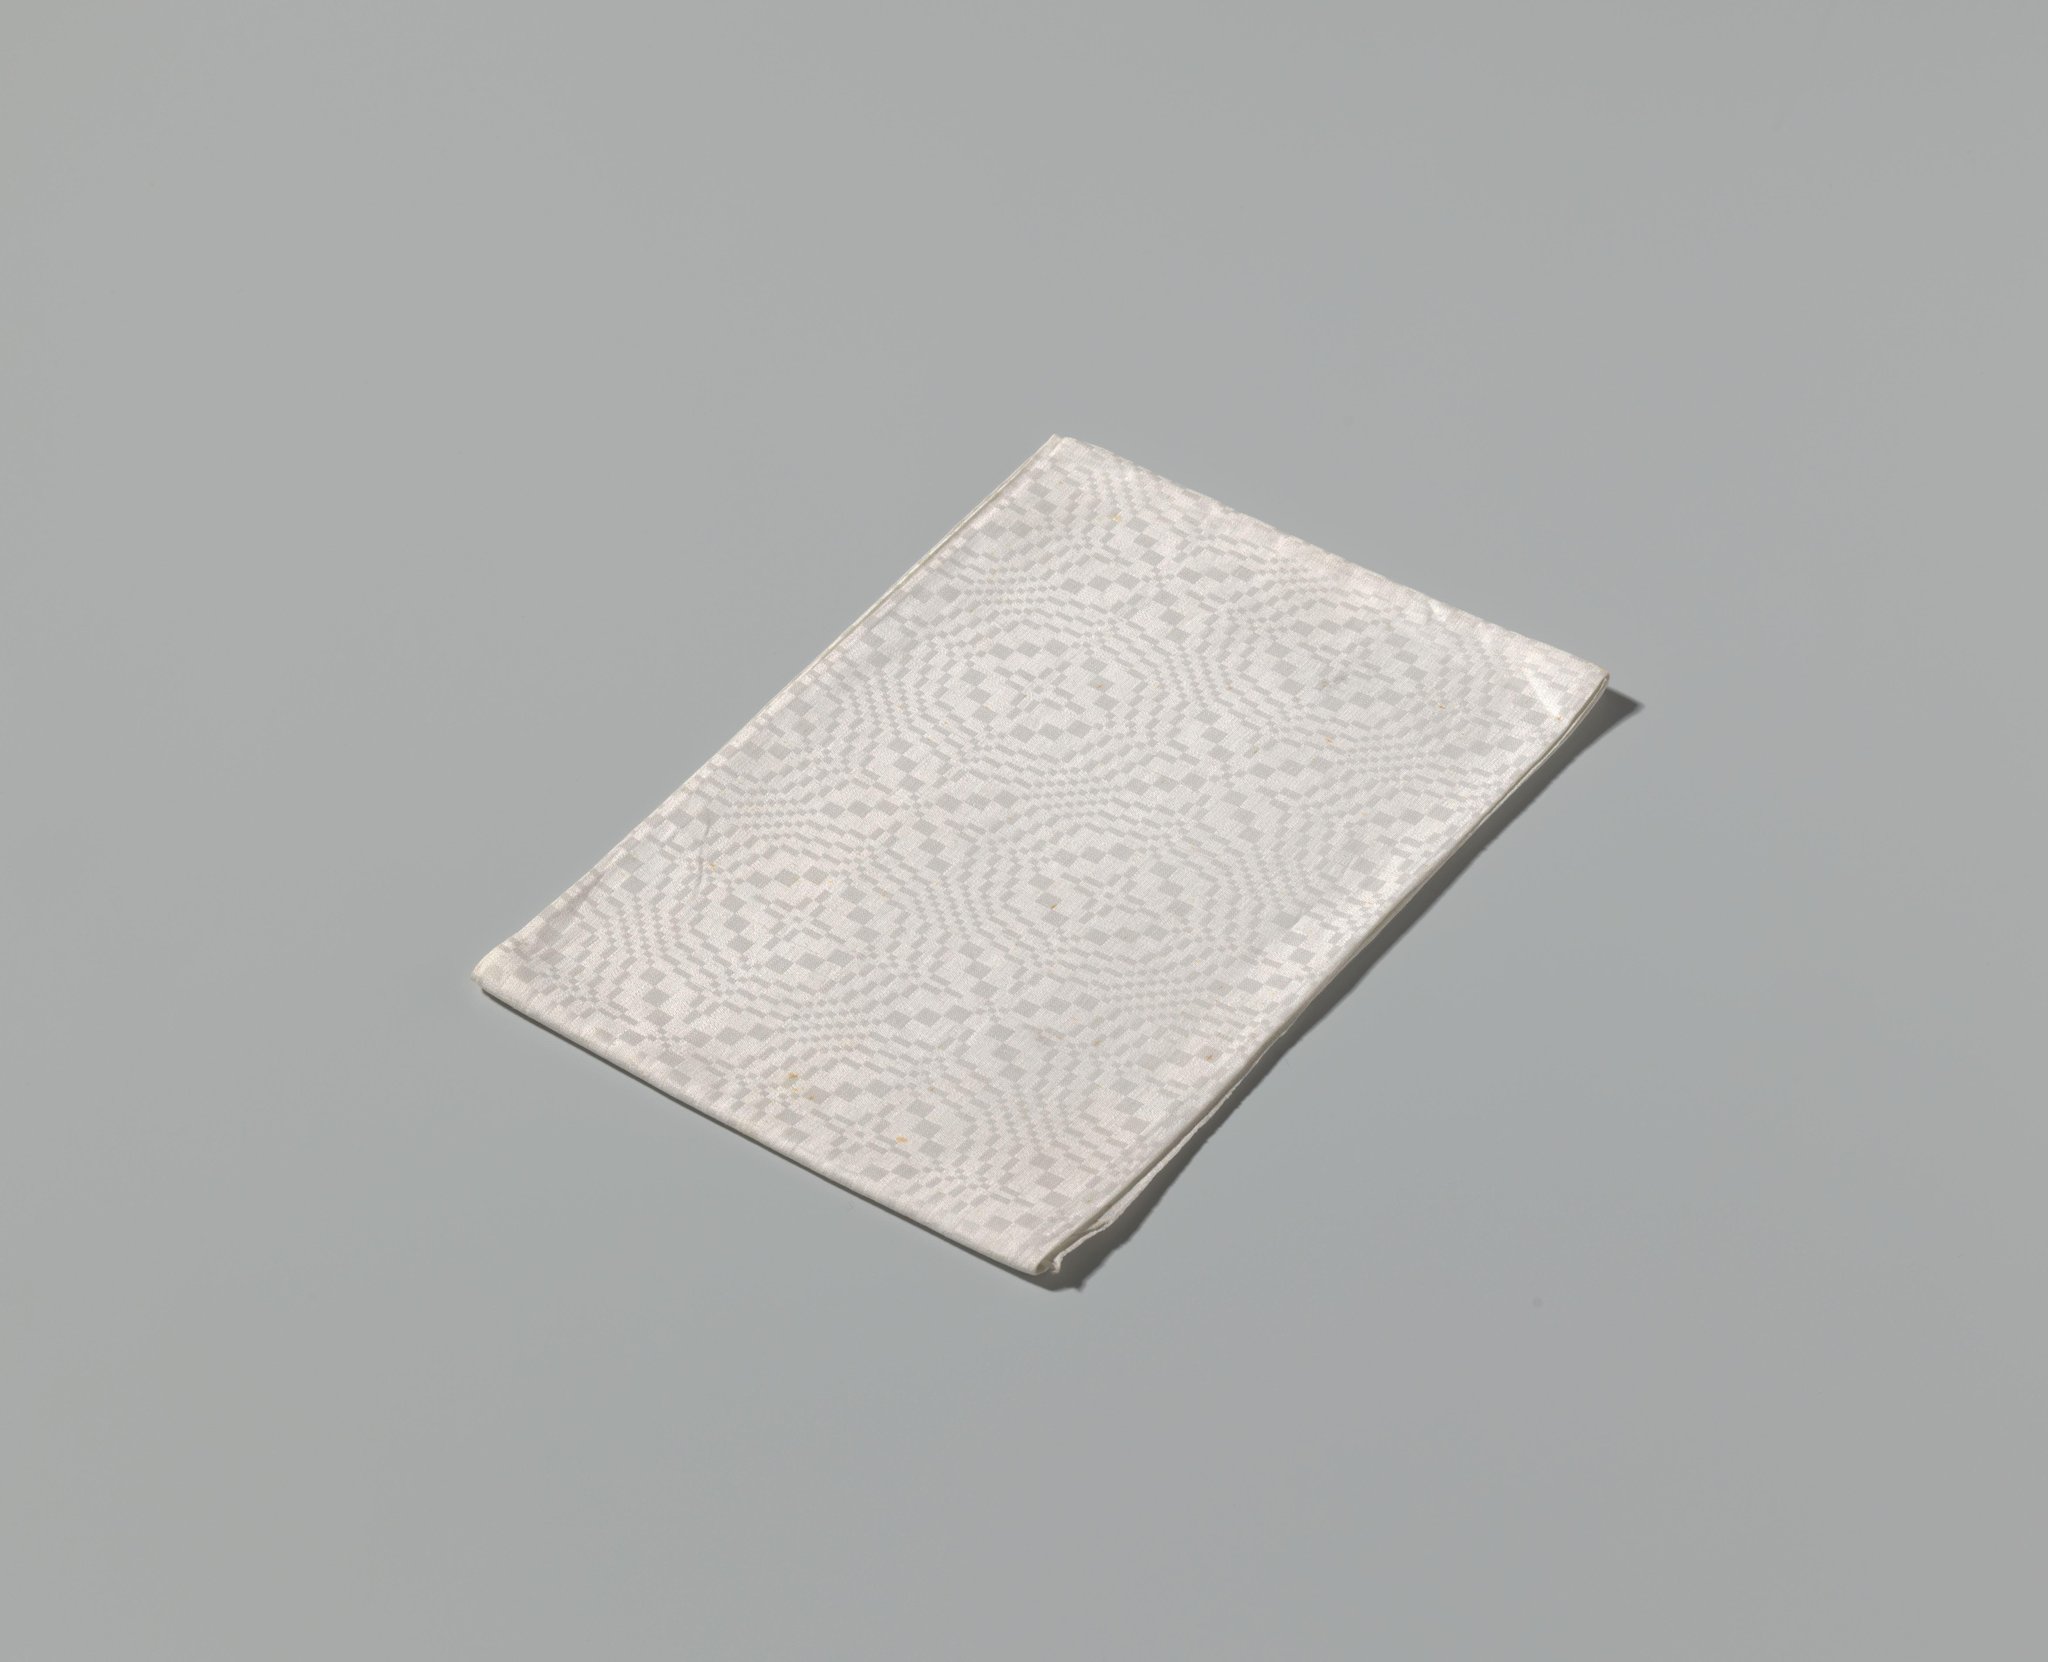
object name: napkin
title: Wit linnen pellen servet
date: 1630-1660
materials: linen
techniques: peeled fabric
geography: northern netherlands